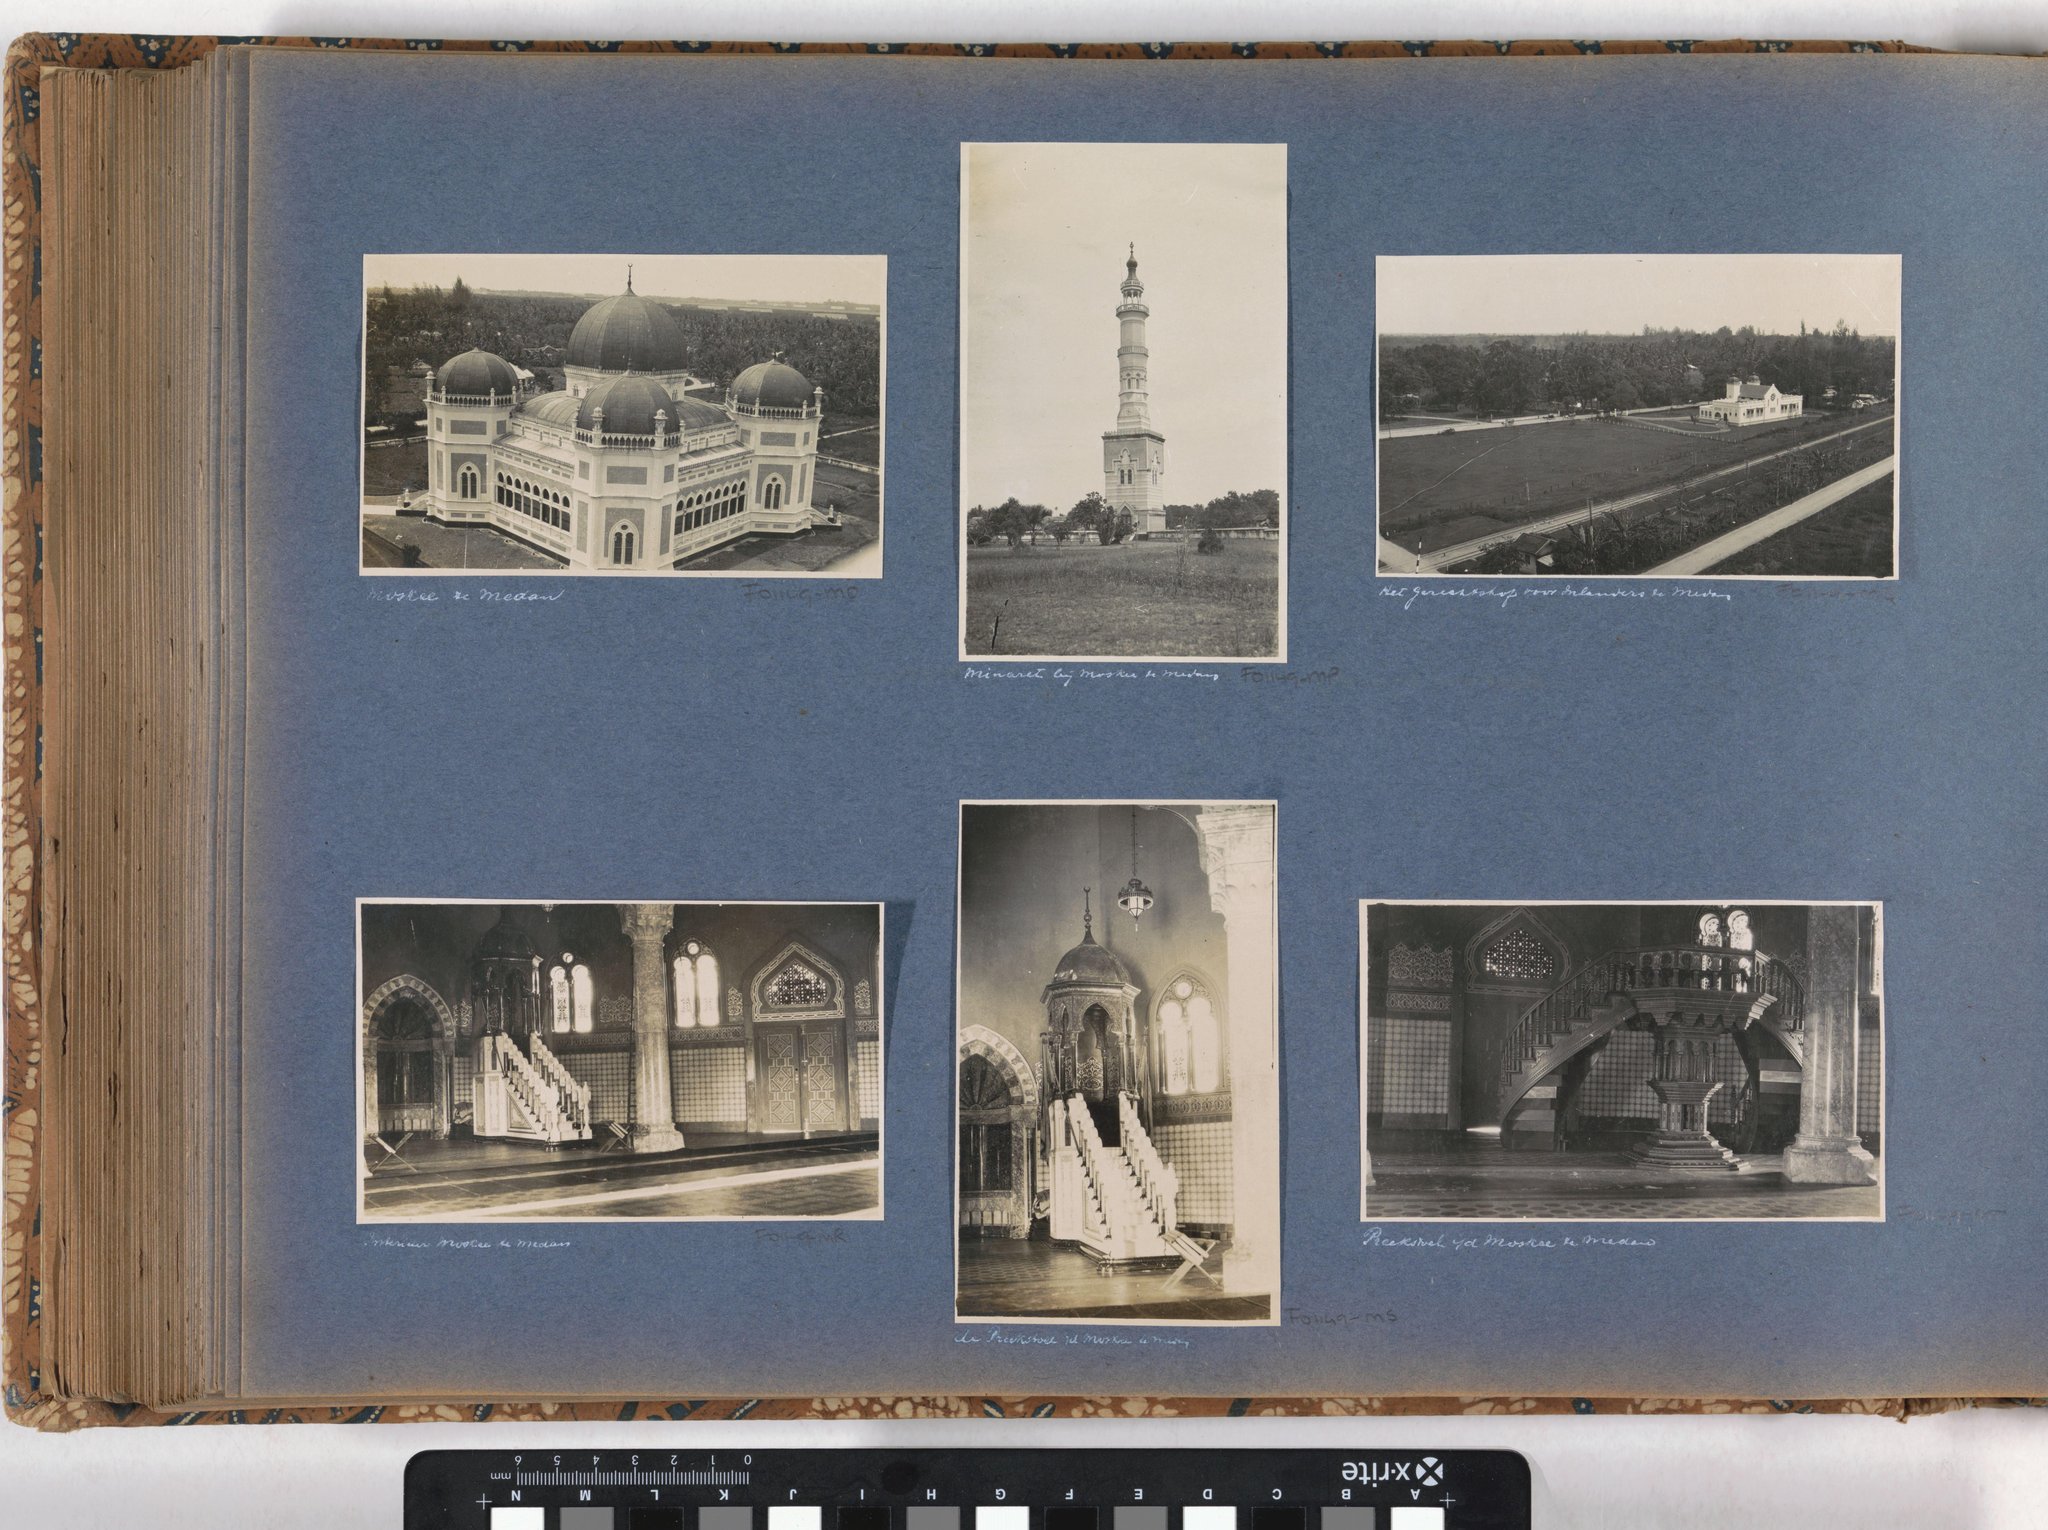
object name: photograph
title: Minaret van de Grote Moskee (Masjid Raya Al Mashun) in Medan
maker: Anonymous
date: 1900-1920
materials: paper, photographic support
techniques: gelatin silver print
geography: medan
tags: temple, shrine ~ islam, mohammedanism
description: Onderdeel van reisalbum met foto's van bedrijvigheid en bezienswaardigheden op Sumatra en Java en van de reis naar en van Nederlands-Indië.